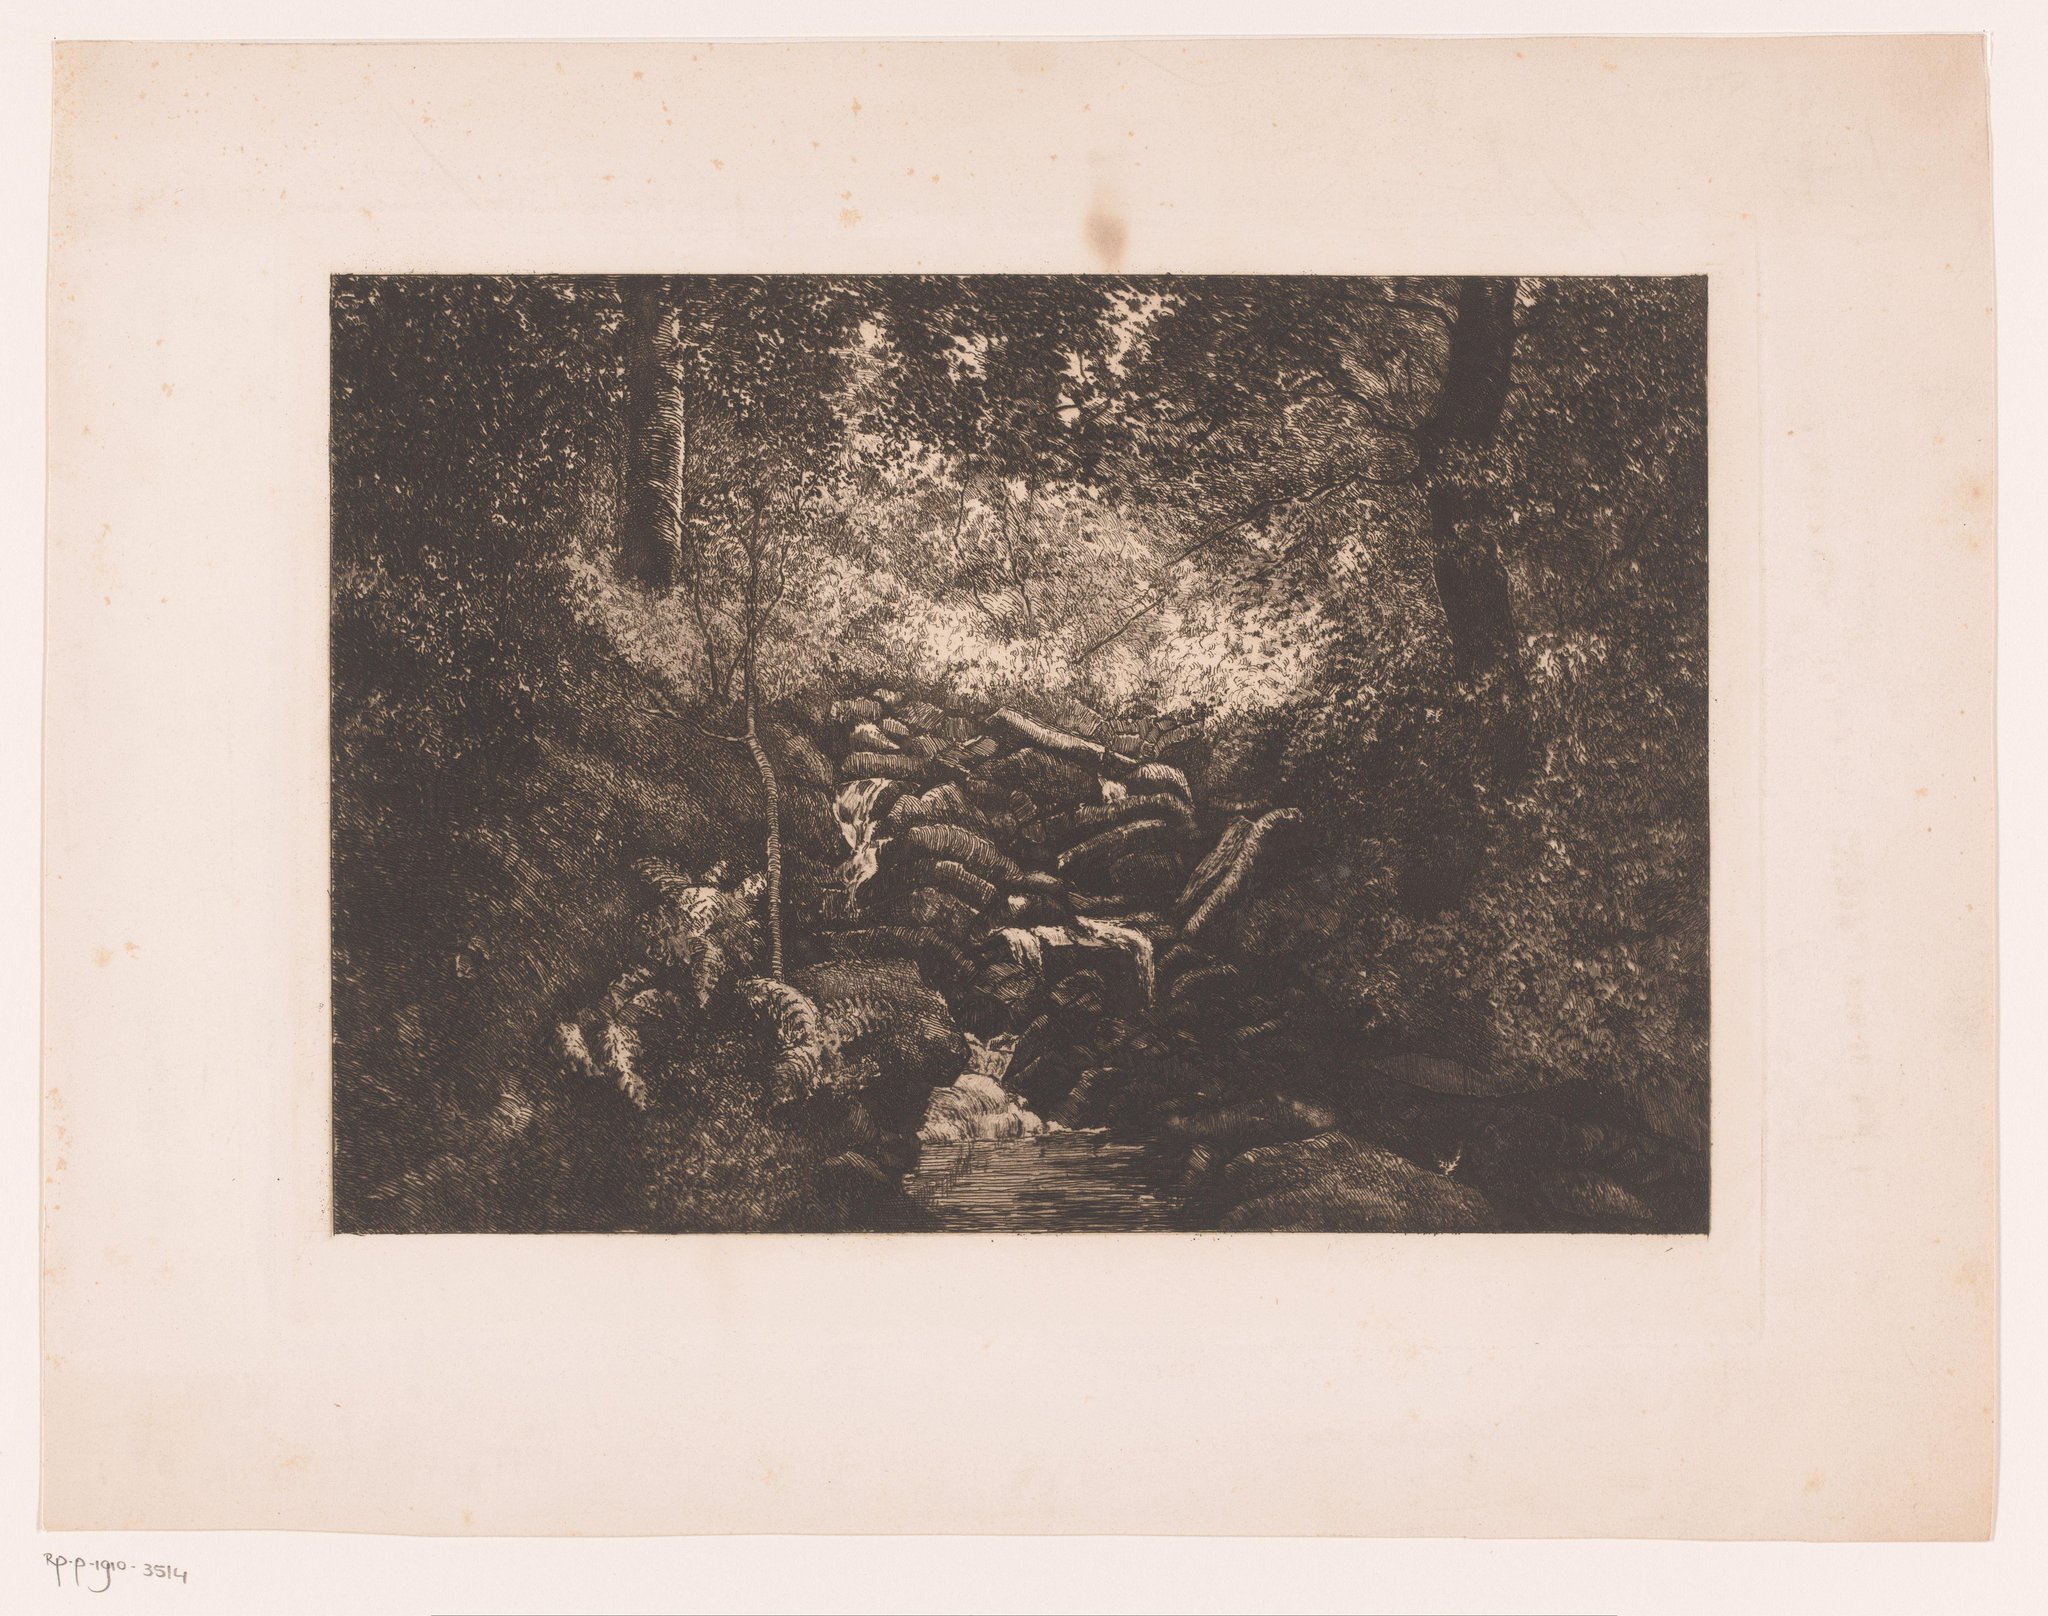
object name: print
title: Bron van een beek in het bos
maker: jules guiette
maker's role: print maker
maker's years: 1852-1901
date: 1862-1901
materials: paper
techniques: drypoint, etching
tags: spring, source of river or stream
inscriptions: collector's mark: Lugt 2228